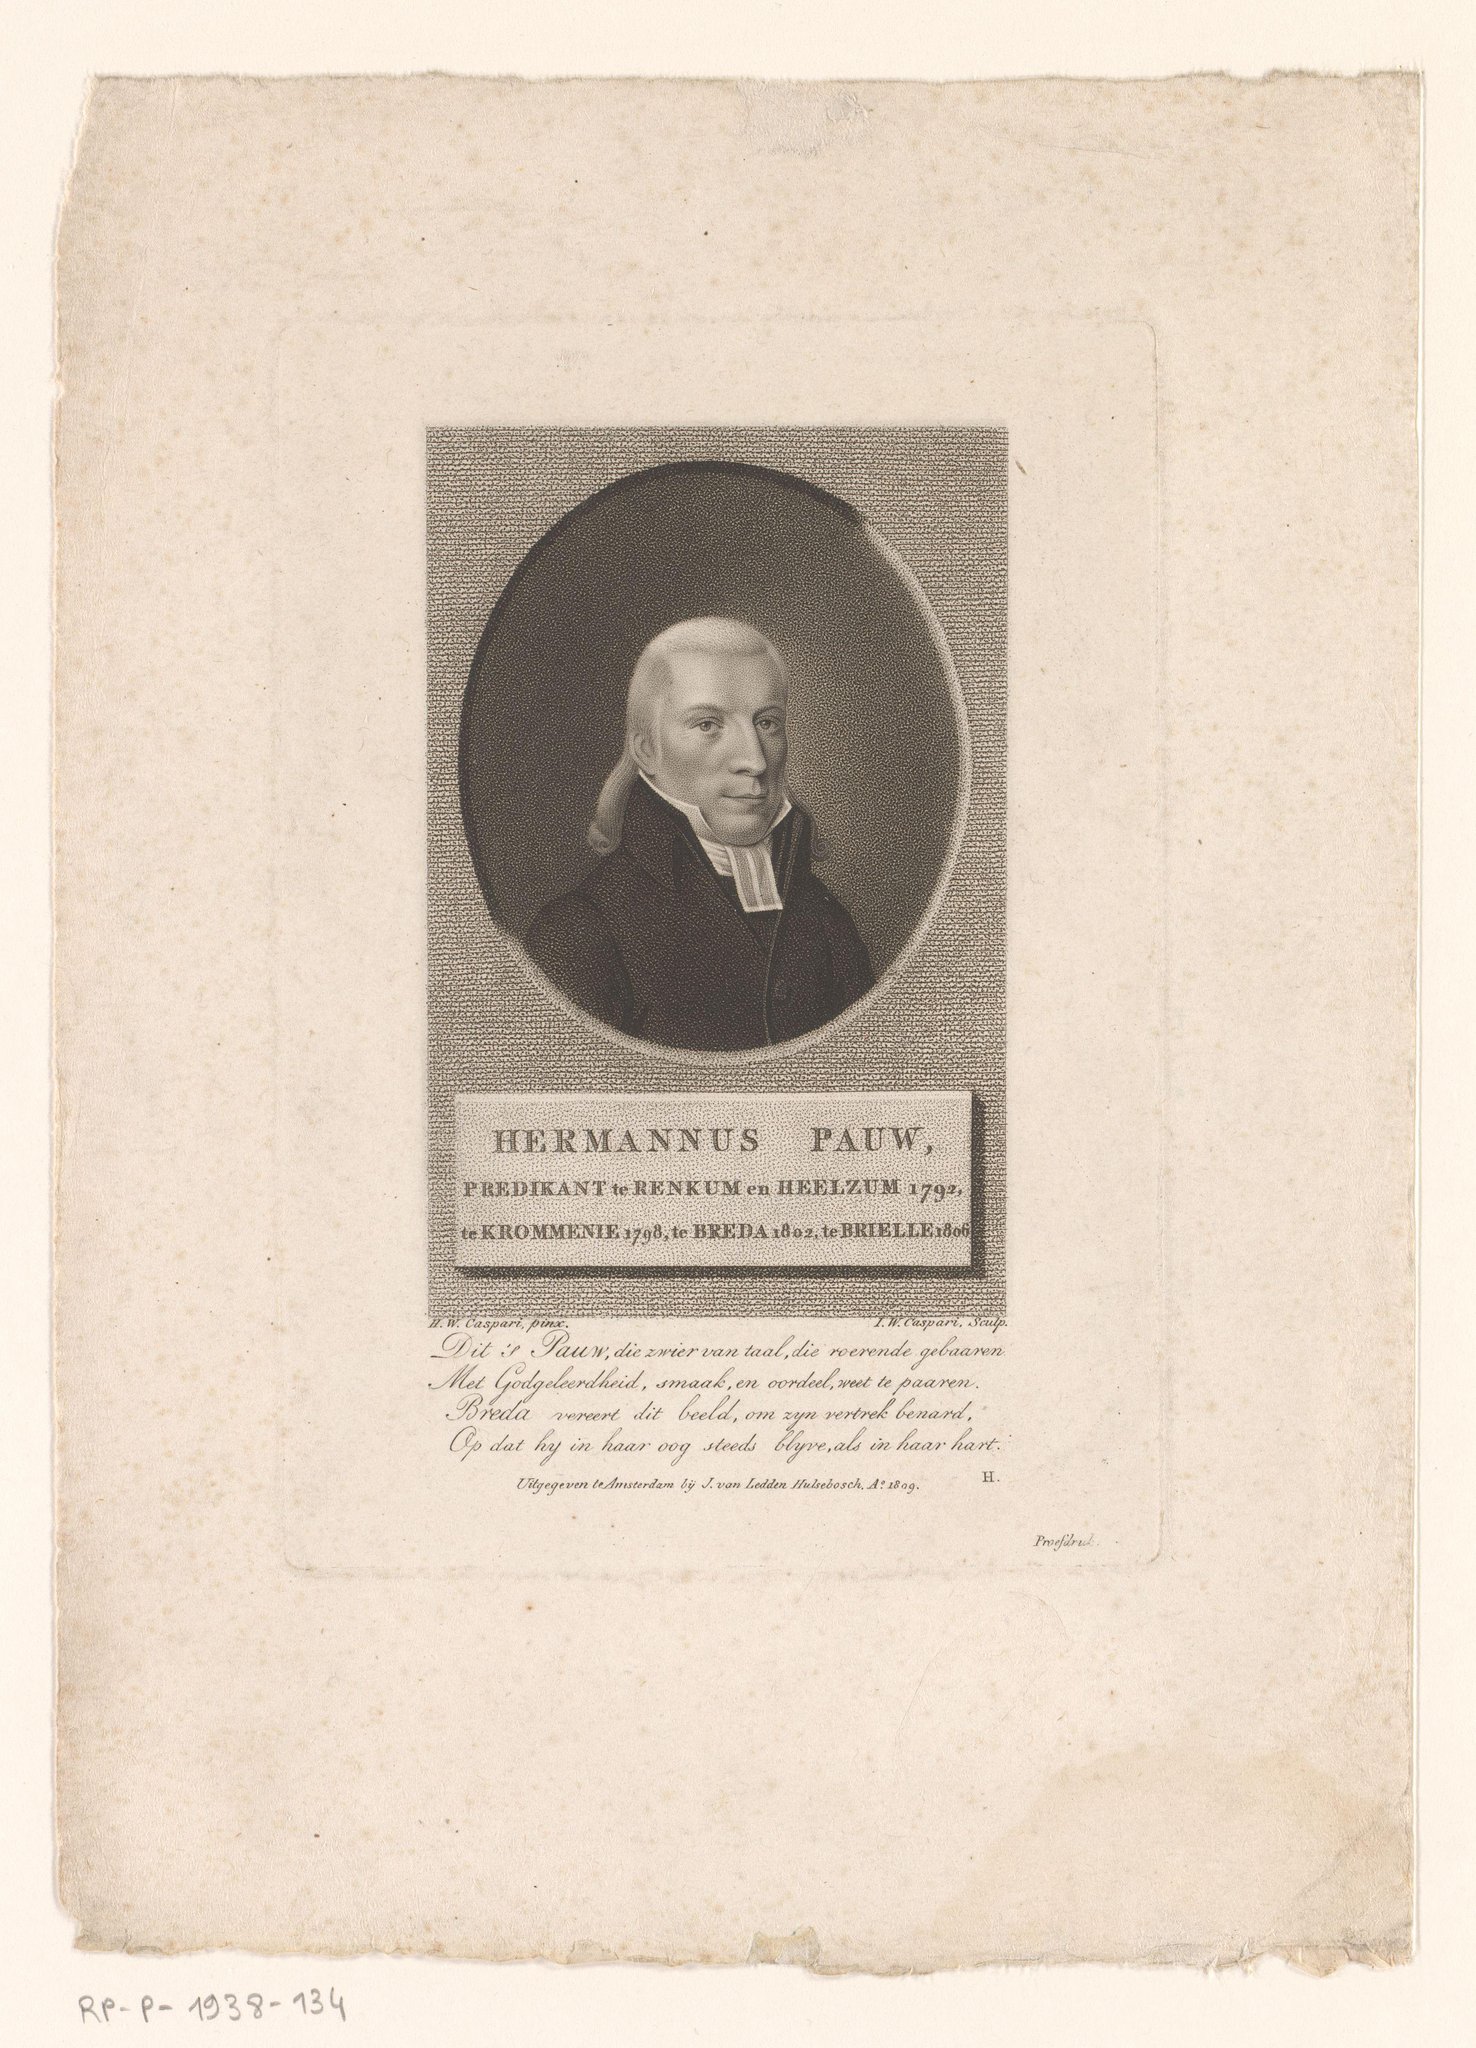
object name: print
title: Portret van Hermannus Pauw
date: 1809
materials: paper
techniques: etching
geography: amsterdam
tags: utrecht, hermannus pauw, historical persons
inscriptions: monogram: ‘H.’, collector's mark: Lugt 2228